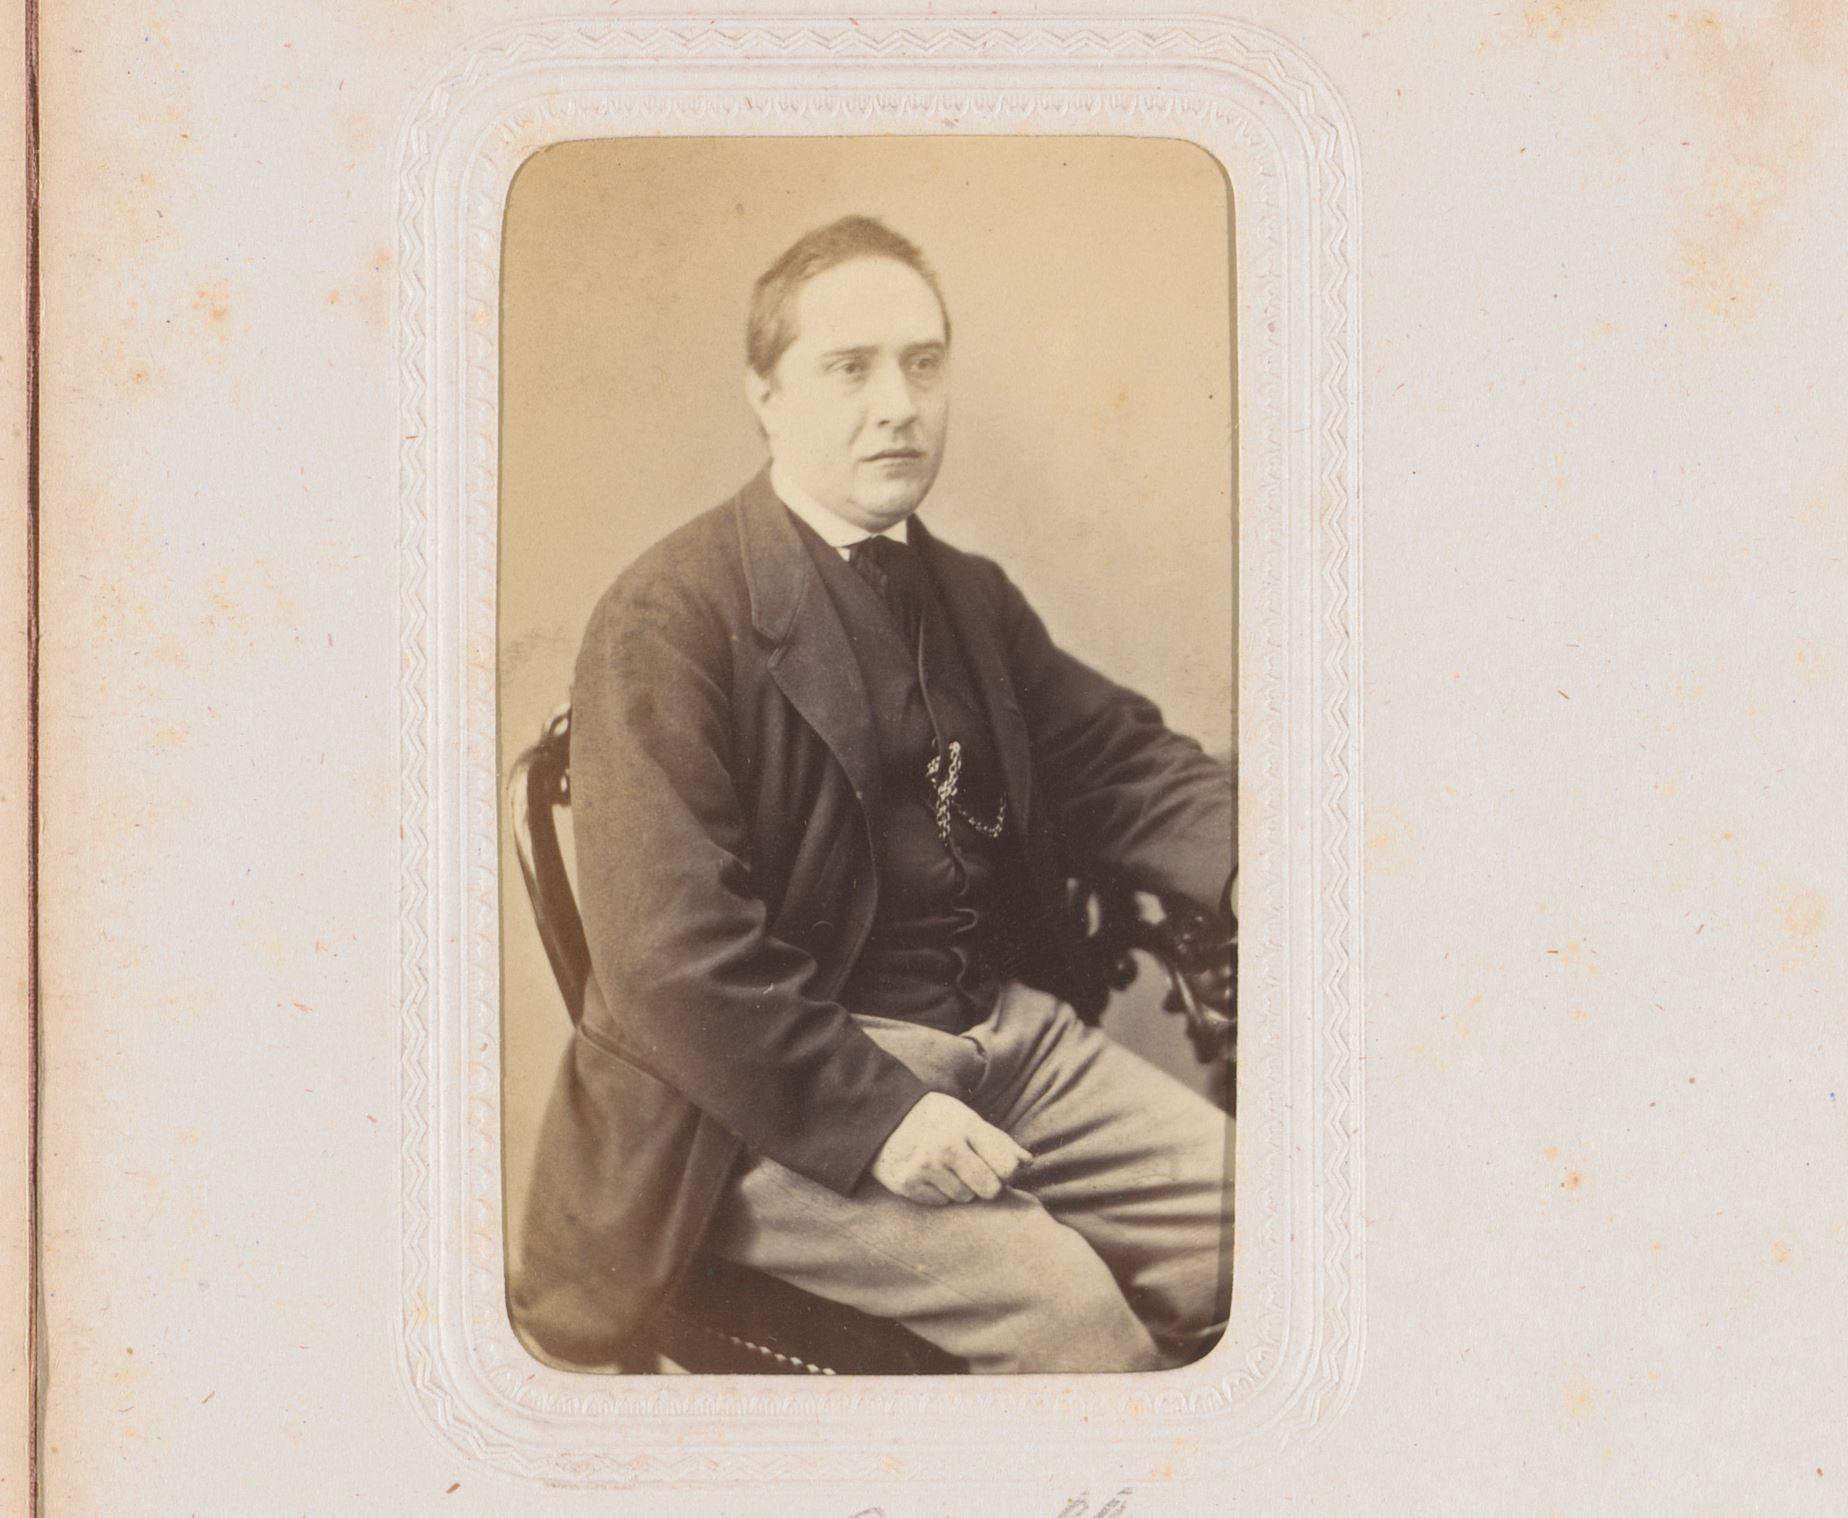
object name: album leaf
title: Portret van een zittende man, aangeduid als F. van Spall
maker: kornelis willem schorteldoek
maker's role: boekbinder, fotograaf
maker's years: 1800-1885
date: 1855-1885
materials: cardboard, photographic support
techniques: albumen print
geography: gorinchem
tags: sitting figure, historical persons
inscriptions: name: ‘van Spall’, annotation: ‘F. van Spall/ Giessendam/ 12 Junÿ 1868.’, inscription: ‘SCHORTELDOEK/ PHOTOGRAAF/ GORINCHEM/ Groote Markt’